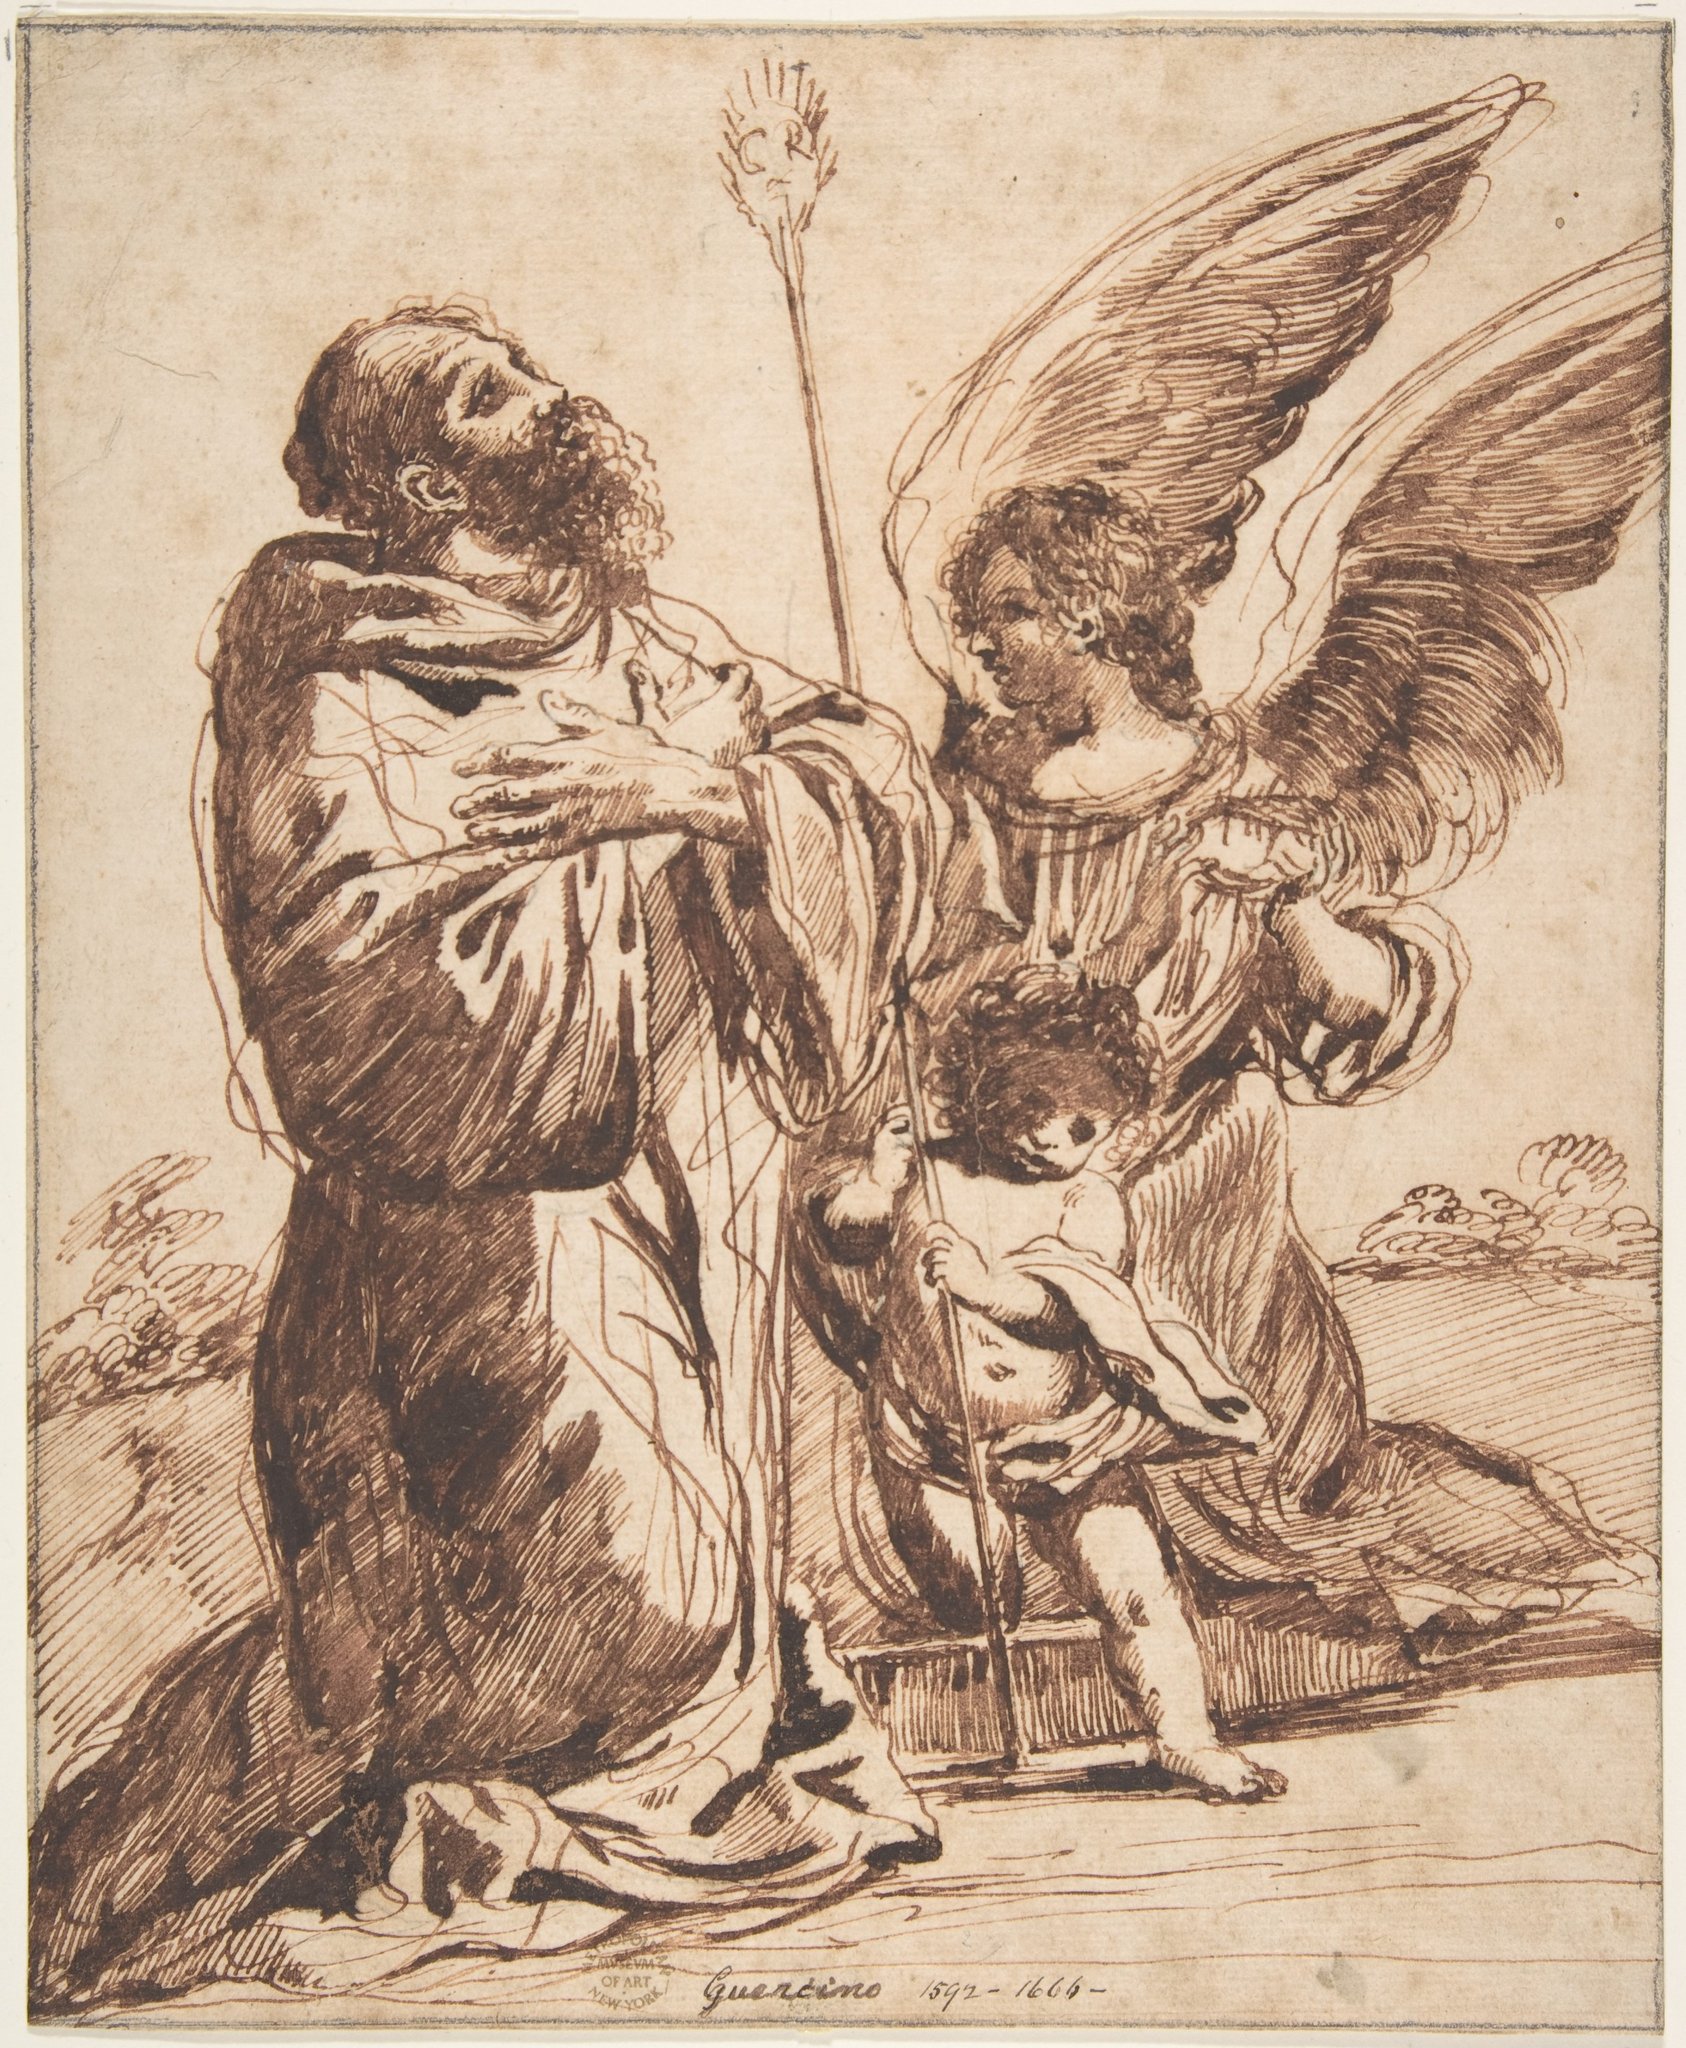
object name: drawing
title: Saint with Angel and Putto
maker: guercino (giovanni francesco barbieri)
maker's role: artist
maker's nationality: italian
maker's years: 1591-1666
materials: ink, drawing material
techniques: brush, pen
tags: putti,angels,saints